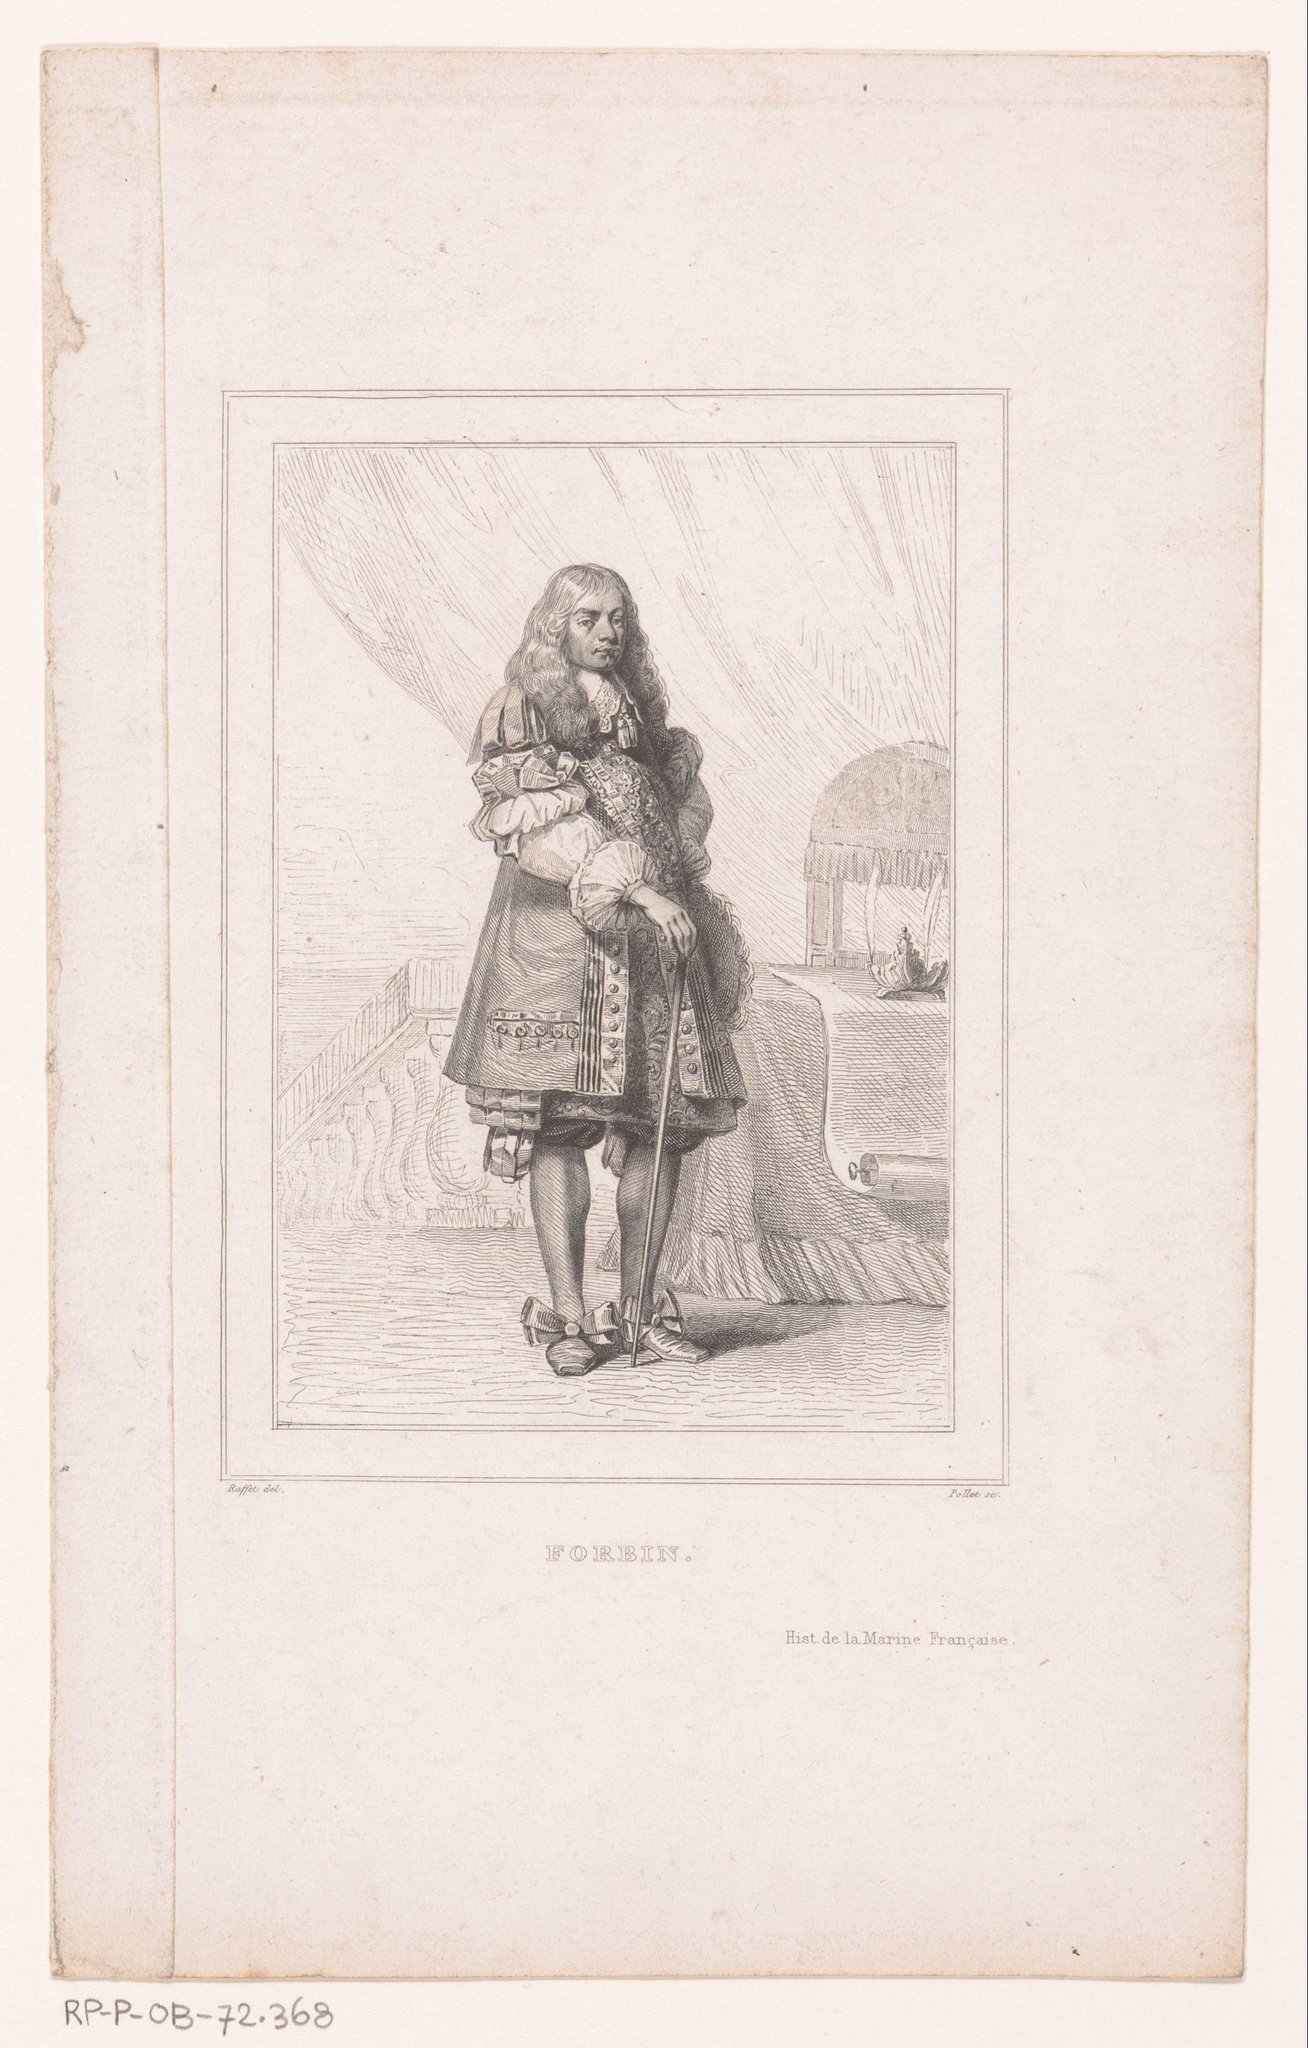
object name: book illustration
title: Portret van Claude de Forbin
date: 1835-1837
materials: paper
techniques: etching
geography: paris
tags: marseille, naval officer, historical persons, ranks in the navy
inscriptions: collector's mark: Lugt 2228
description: Prent uit: Sue, Eugène. Histoire de la marine française. Parijs: Félix Bonnaire, 1835-1837, 5 delen.